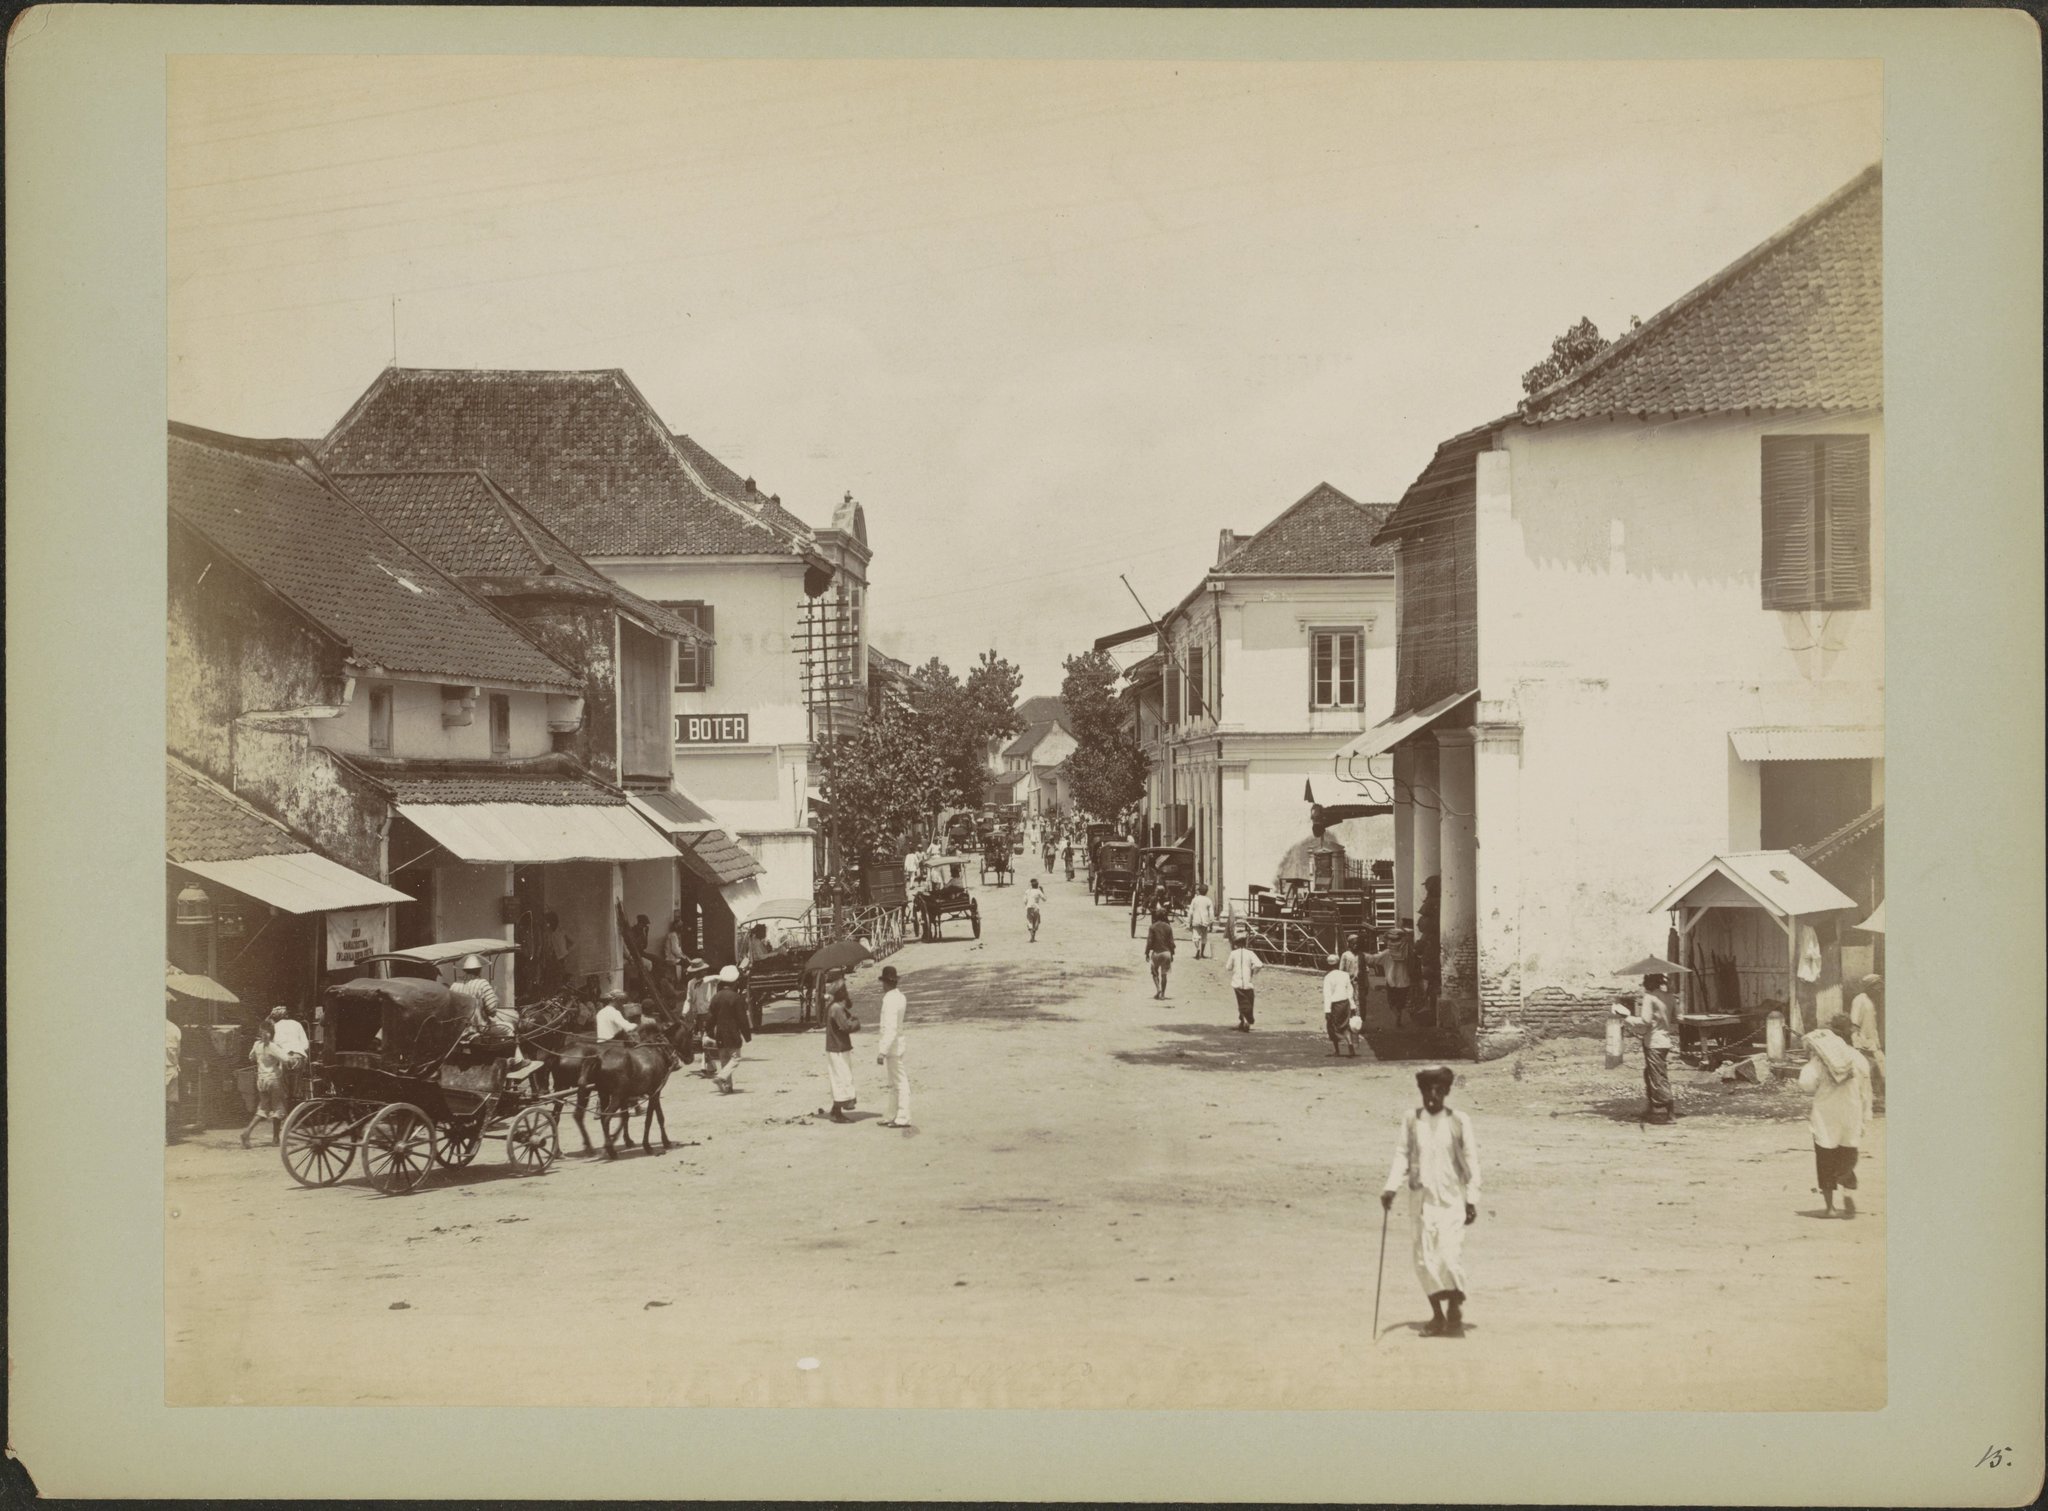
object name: album leaf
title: Straatgezicht in het Chinese kamp in Soerabaja met huizen, rijtuigen en voorbijgangers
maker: Anonymous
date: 1870-1910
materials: cardboard, paper, photographic support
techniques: albumen print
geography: surabaya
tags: street (+ city(-scape) with figures, staffage), surabaya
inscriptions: inscription: ‘Chineesche kamp te Soerabaia’, inscription: ‘B.F.K. Rives No. 74’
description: Onderdeel van Reisalbum met foto's van bezienswaardigheden in Marseille, Port Said, Aden, Bombay, Colombo, Singapore en Nederlands-Indië.